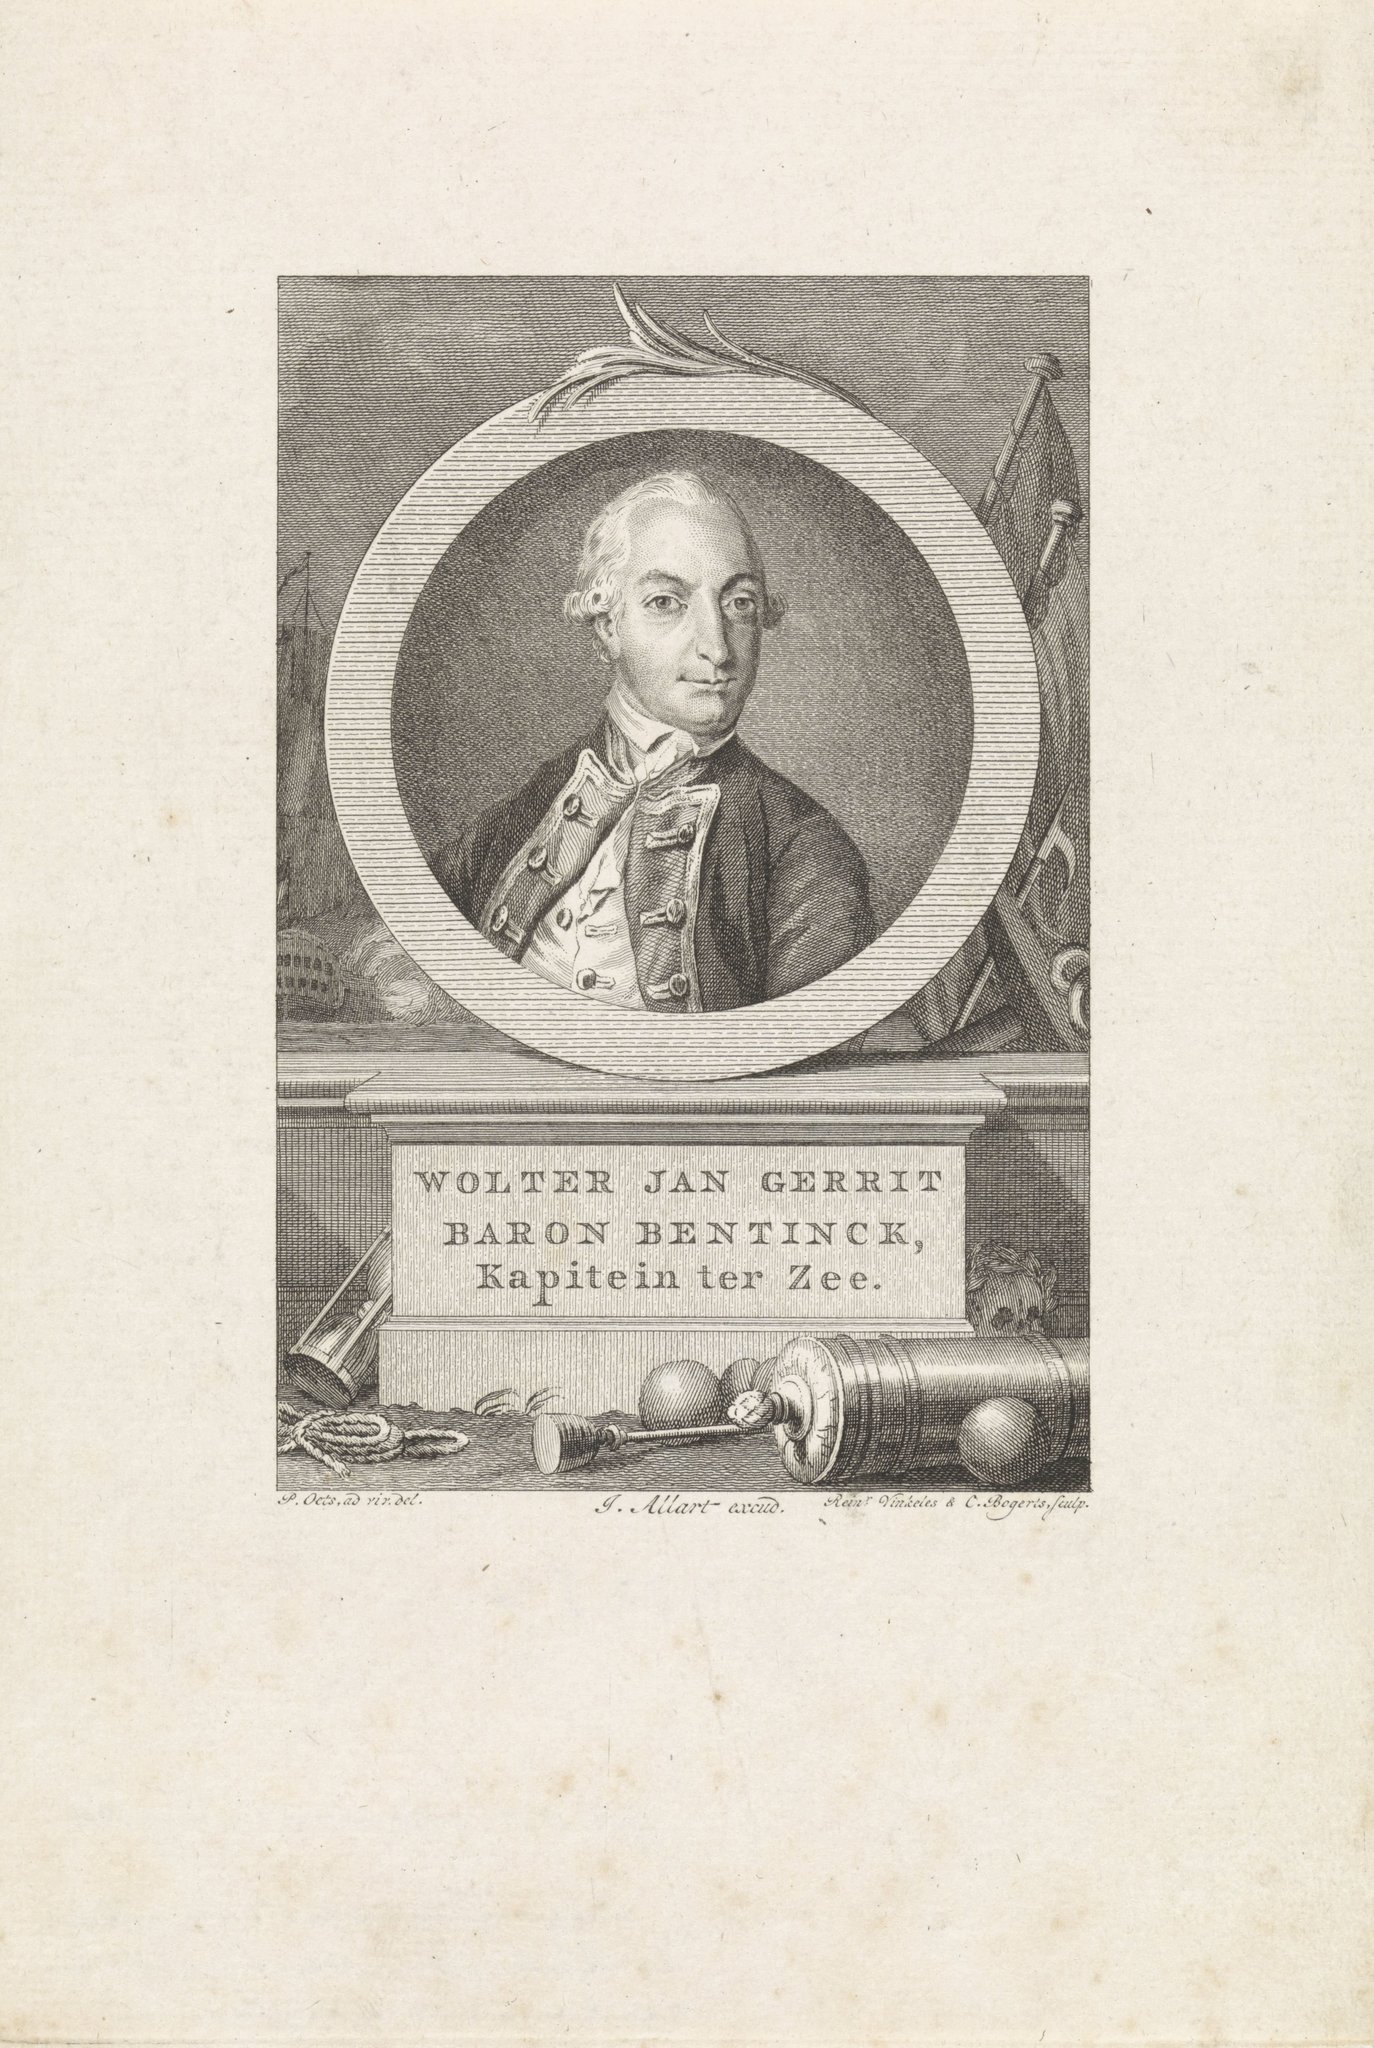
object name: print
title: Portret van Wolter Jan Gerit Baron Bentinck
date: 1755-1816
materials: paper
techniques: engraving, etching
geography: amsterdam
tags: amsterdam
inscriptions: collector's mark: Lugt 2228, inscription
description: Portret van Wolter Jan Gerit Baron Bentinck, schout bij nacht van Holland en West-Friesland.